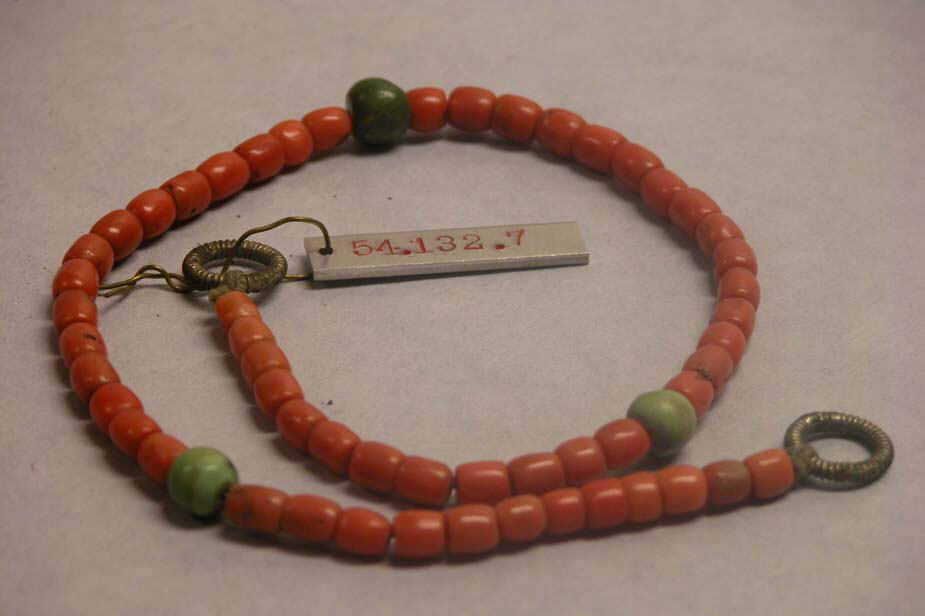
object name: bead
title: String of Beads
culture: tibetan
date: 1801-1900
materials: jade, silver